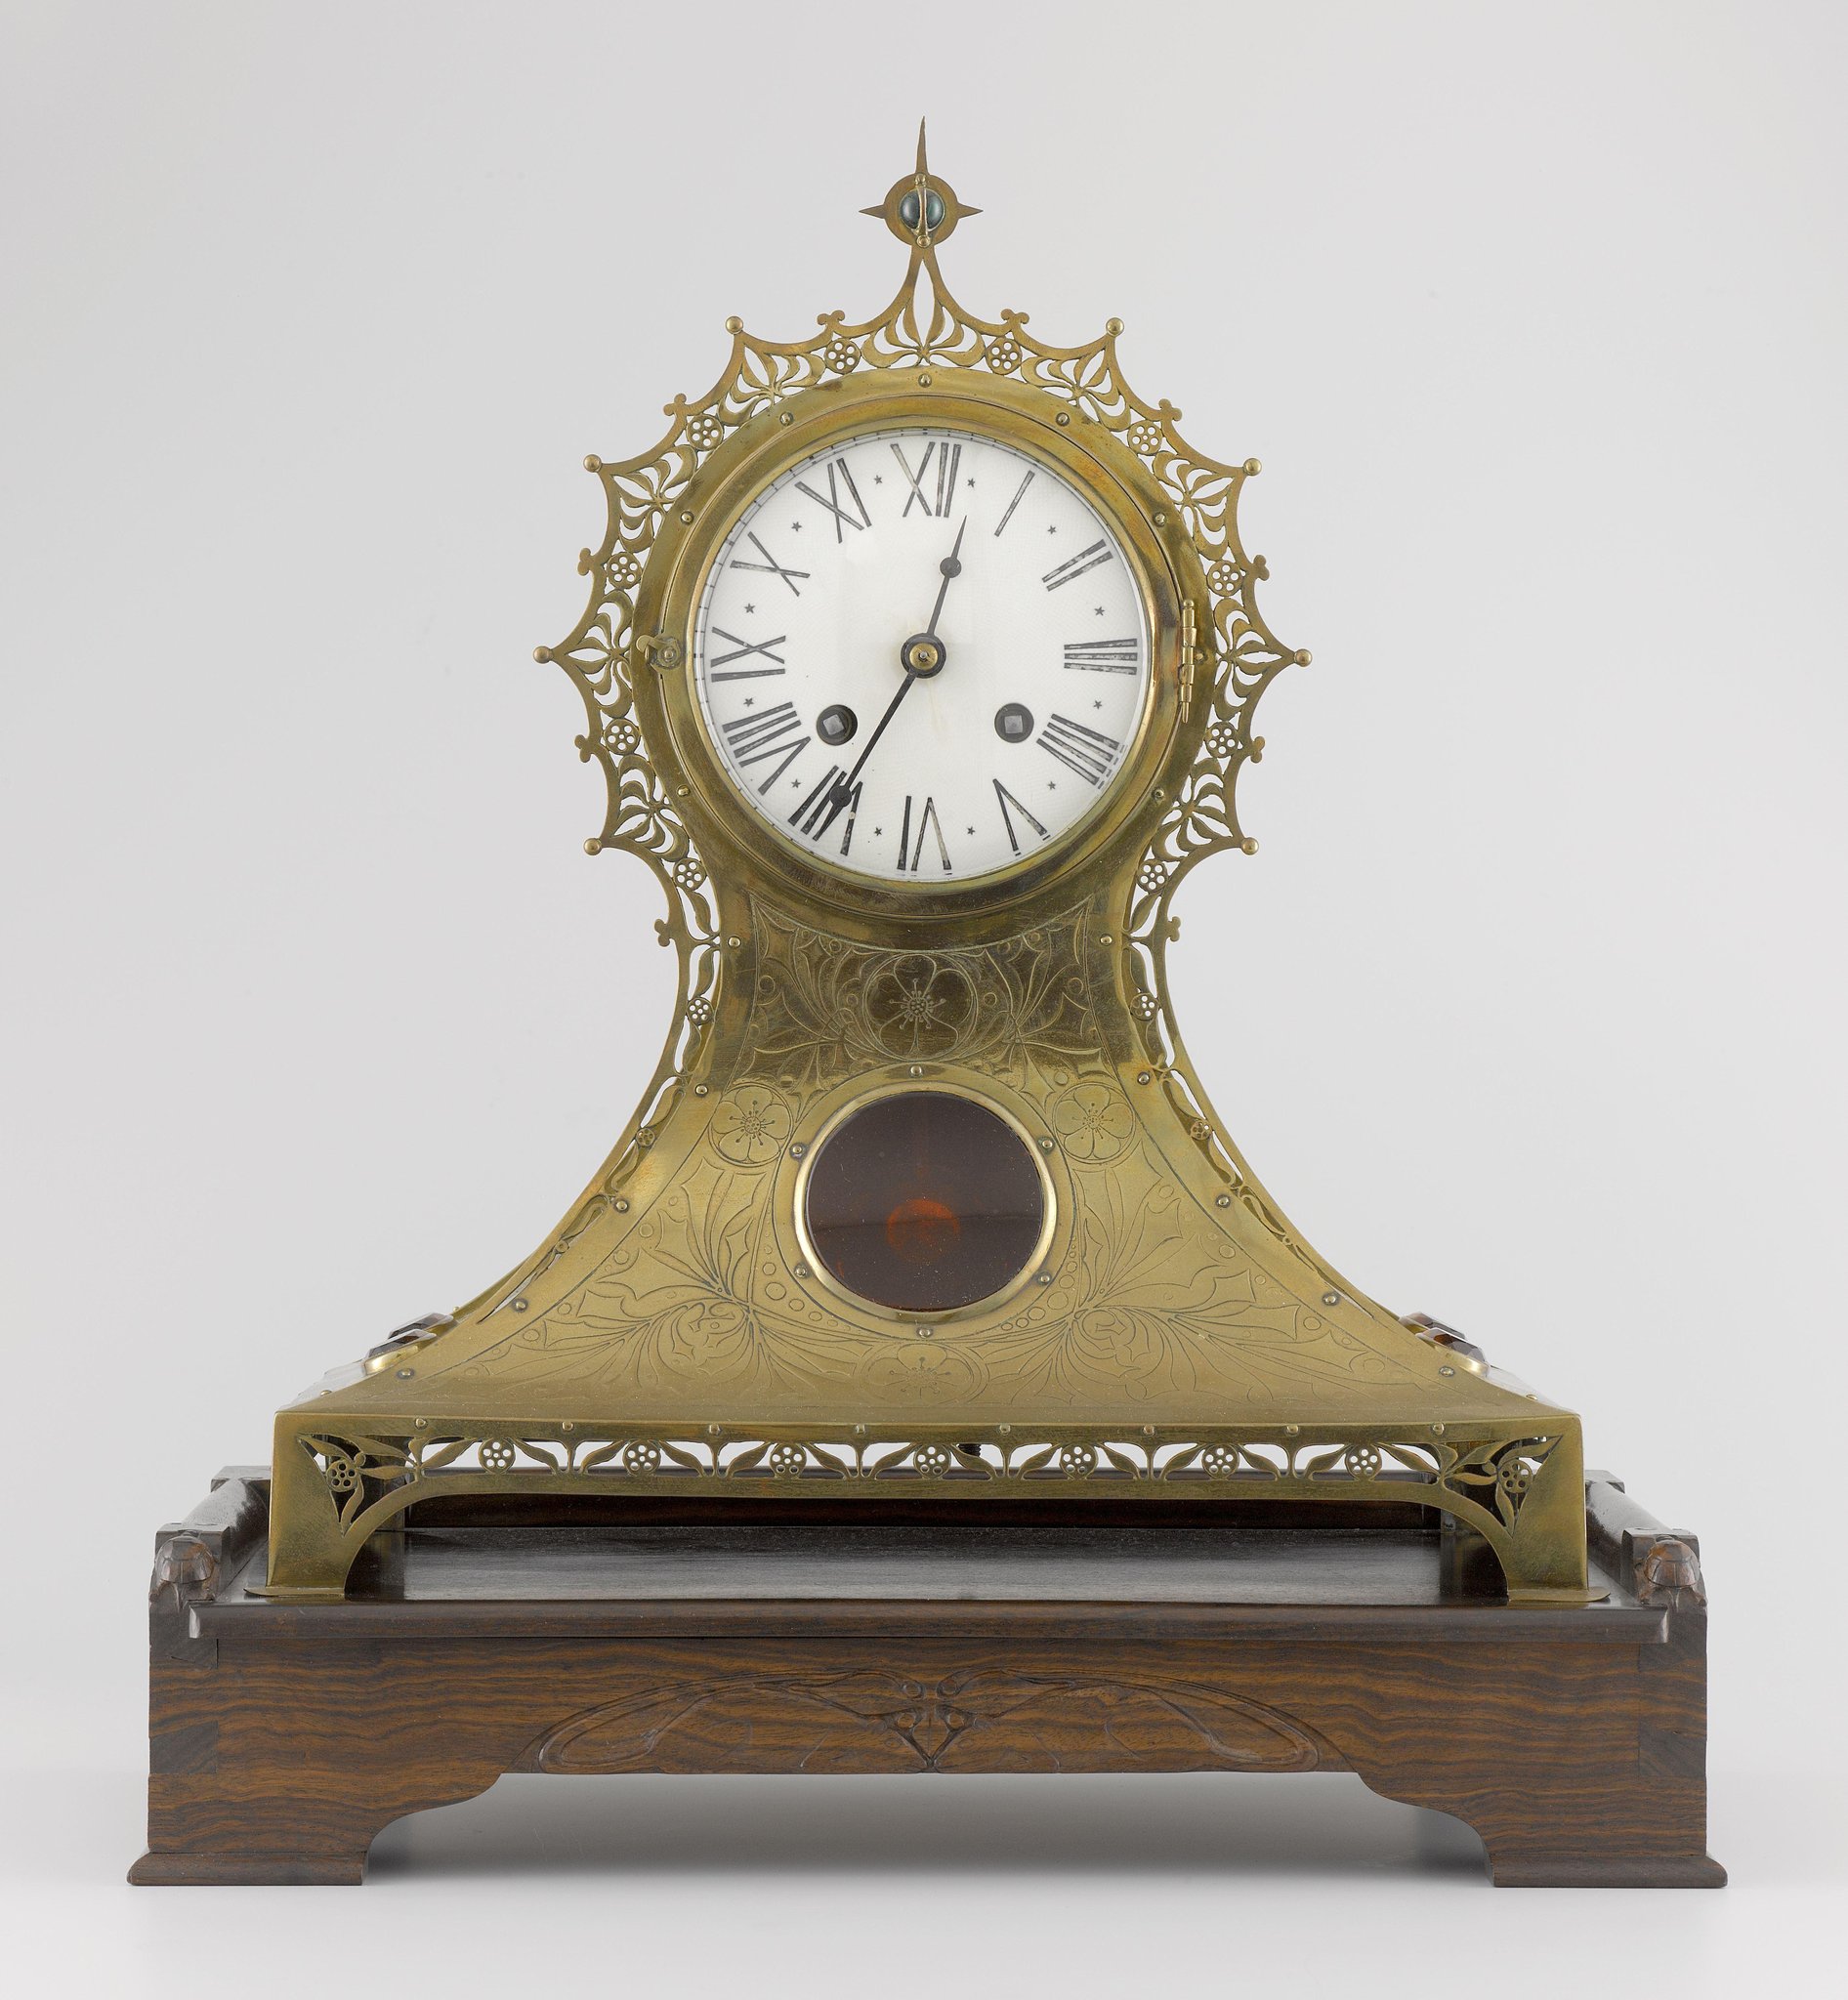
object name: mantel clock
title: Houten voetstuk van een pendule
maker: theo nieuwenhuis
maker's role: designer, draughtsman, print maker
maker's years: 1866-1951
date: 1898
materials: wood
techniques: cutting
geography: amsterdam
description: Het voetstuk van coromandelhout heeft aan de voorzijde een gesneden ornament met bladeren en twee muizen, alsmede op iedere zijkant een muis. Op de einden van de rand is een schildpad uitgesneden.